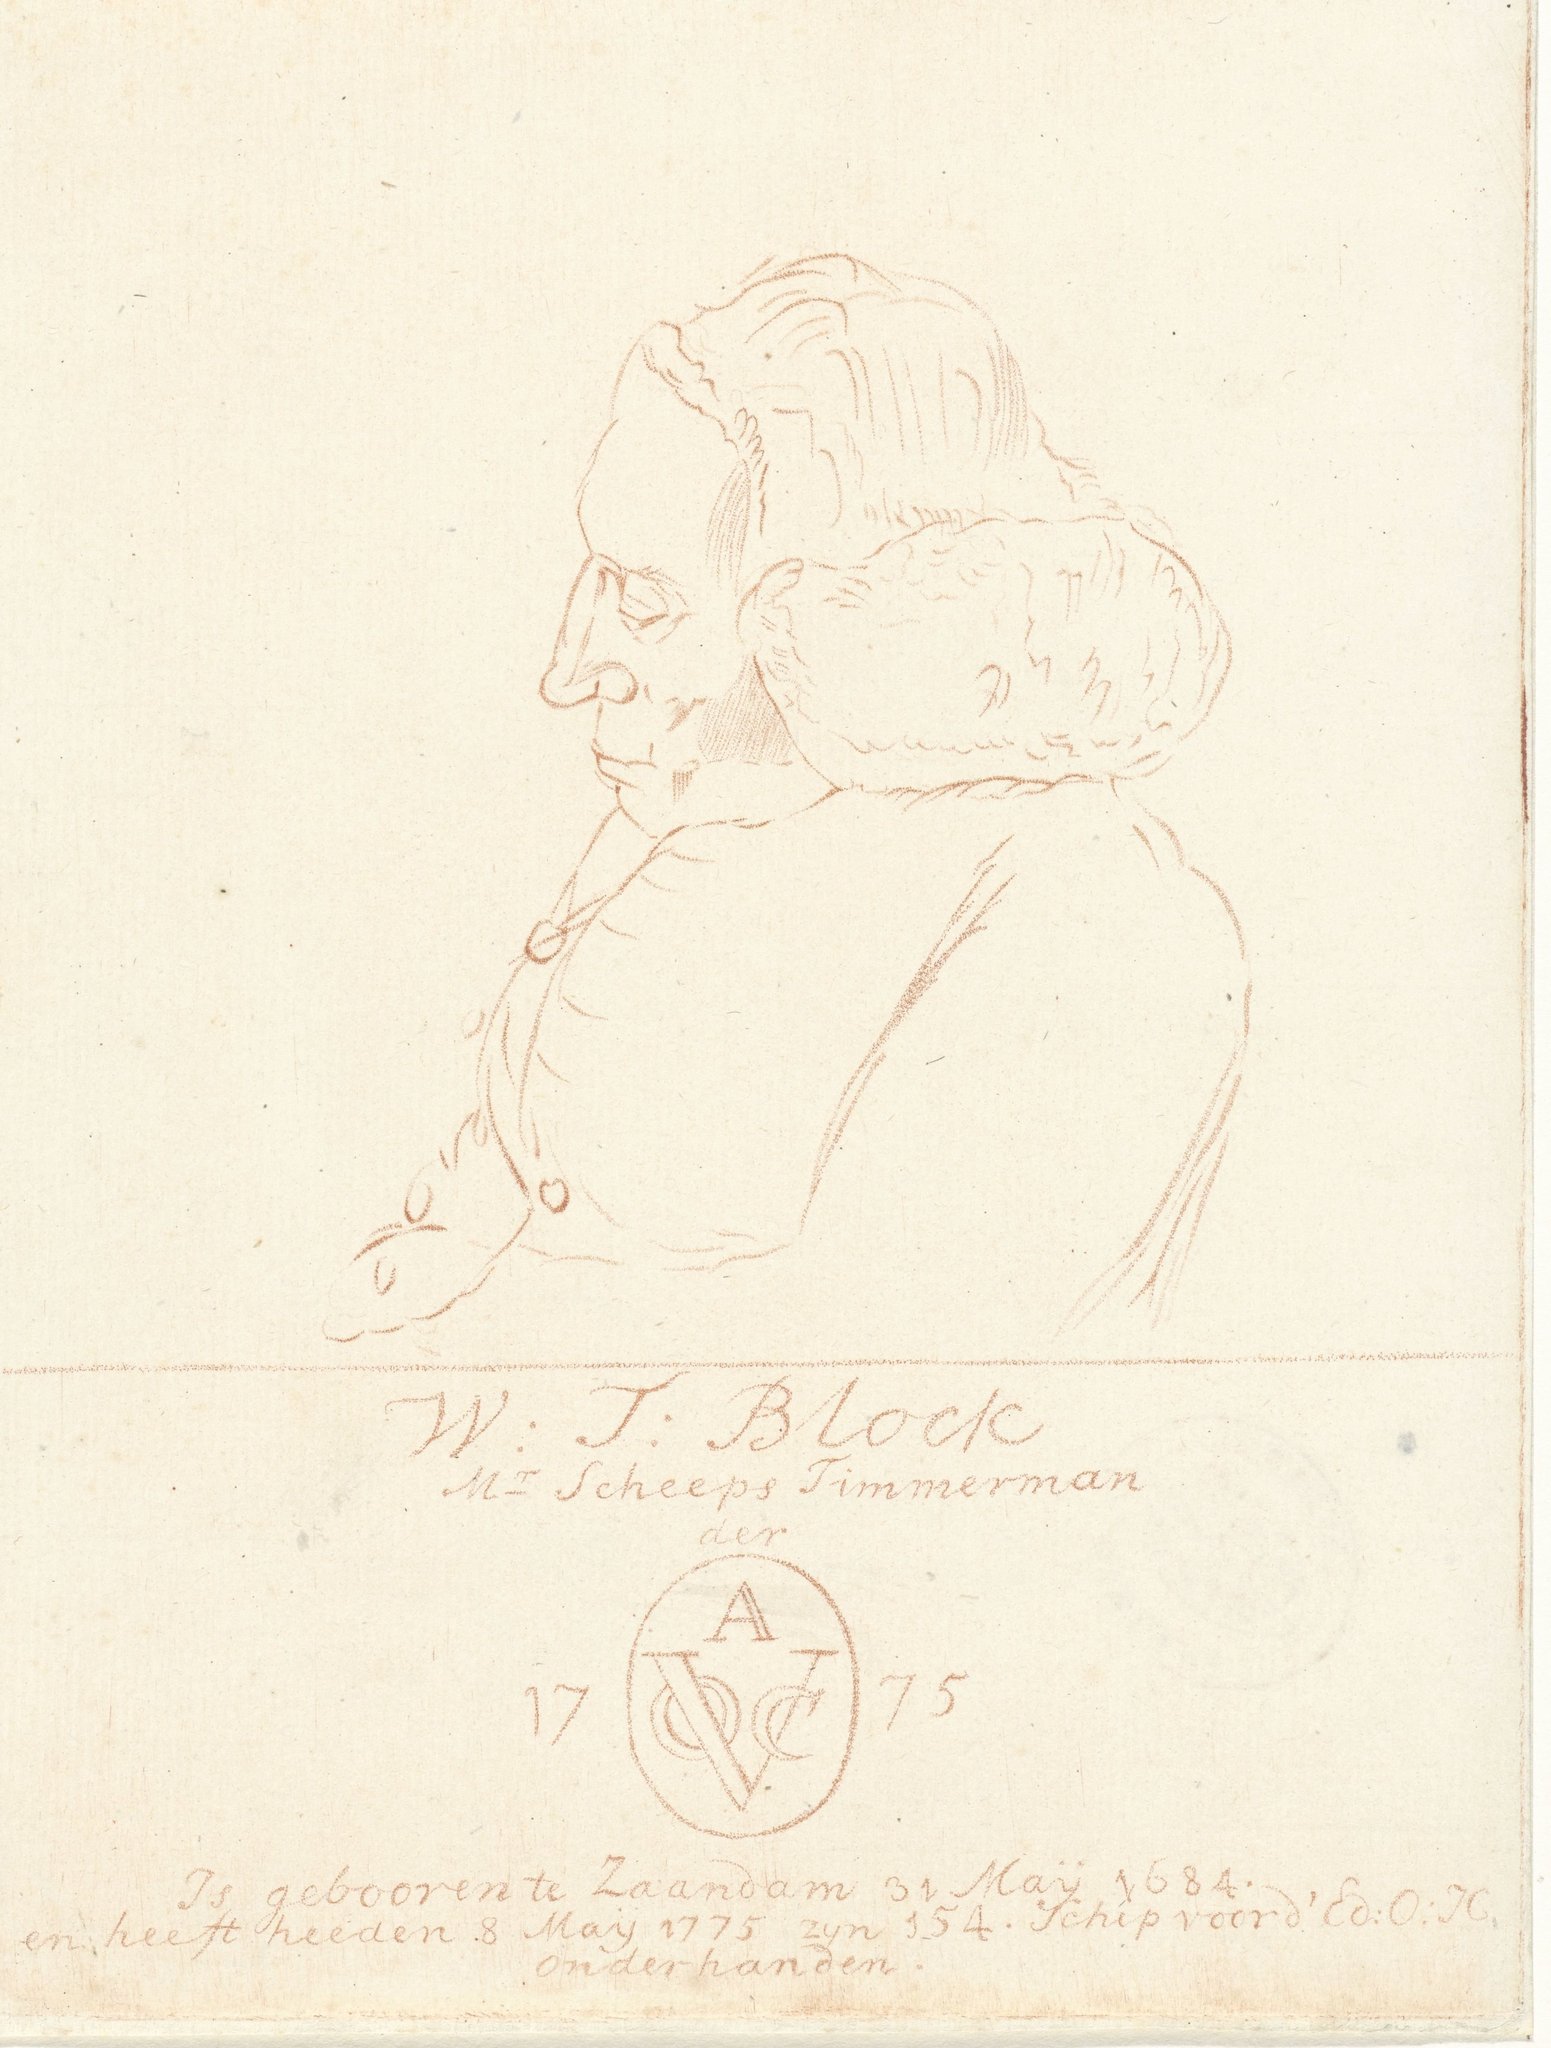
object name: print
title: Portret van Willem Teunisz. Block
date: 1775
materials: paper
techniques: printing, printmaking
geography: amsterdam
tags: zaandam, willem teunisz. block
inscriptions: inscription: ‘geoffreerd aan B. Schreuder PvA / PvA f’, collector's mark: Lugt 240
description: Portret van Willem Teunisz. Block, scheepstimmerman voor de VOC.